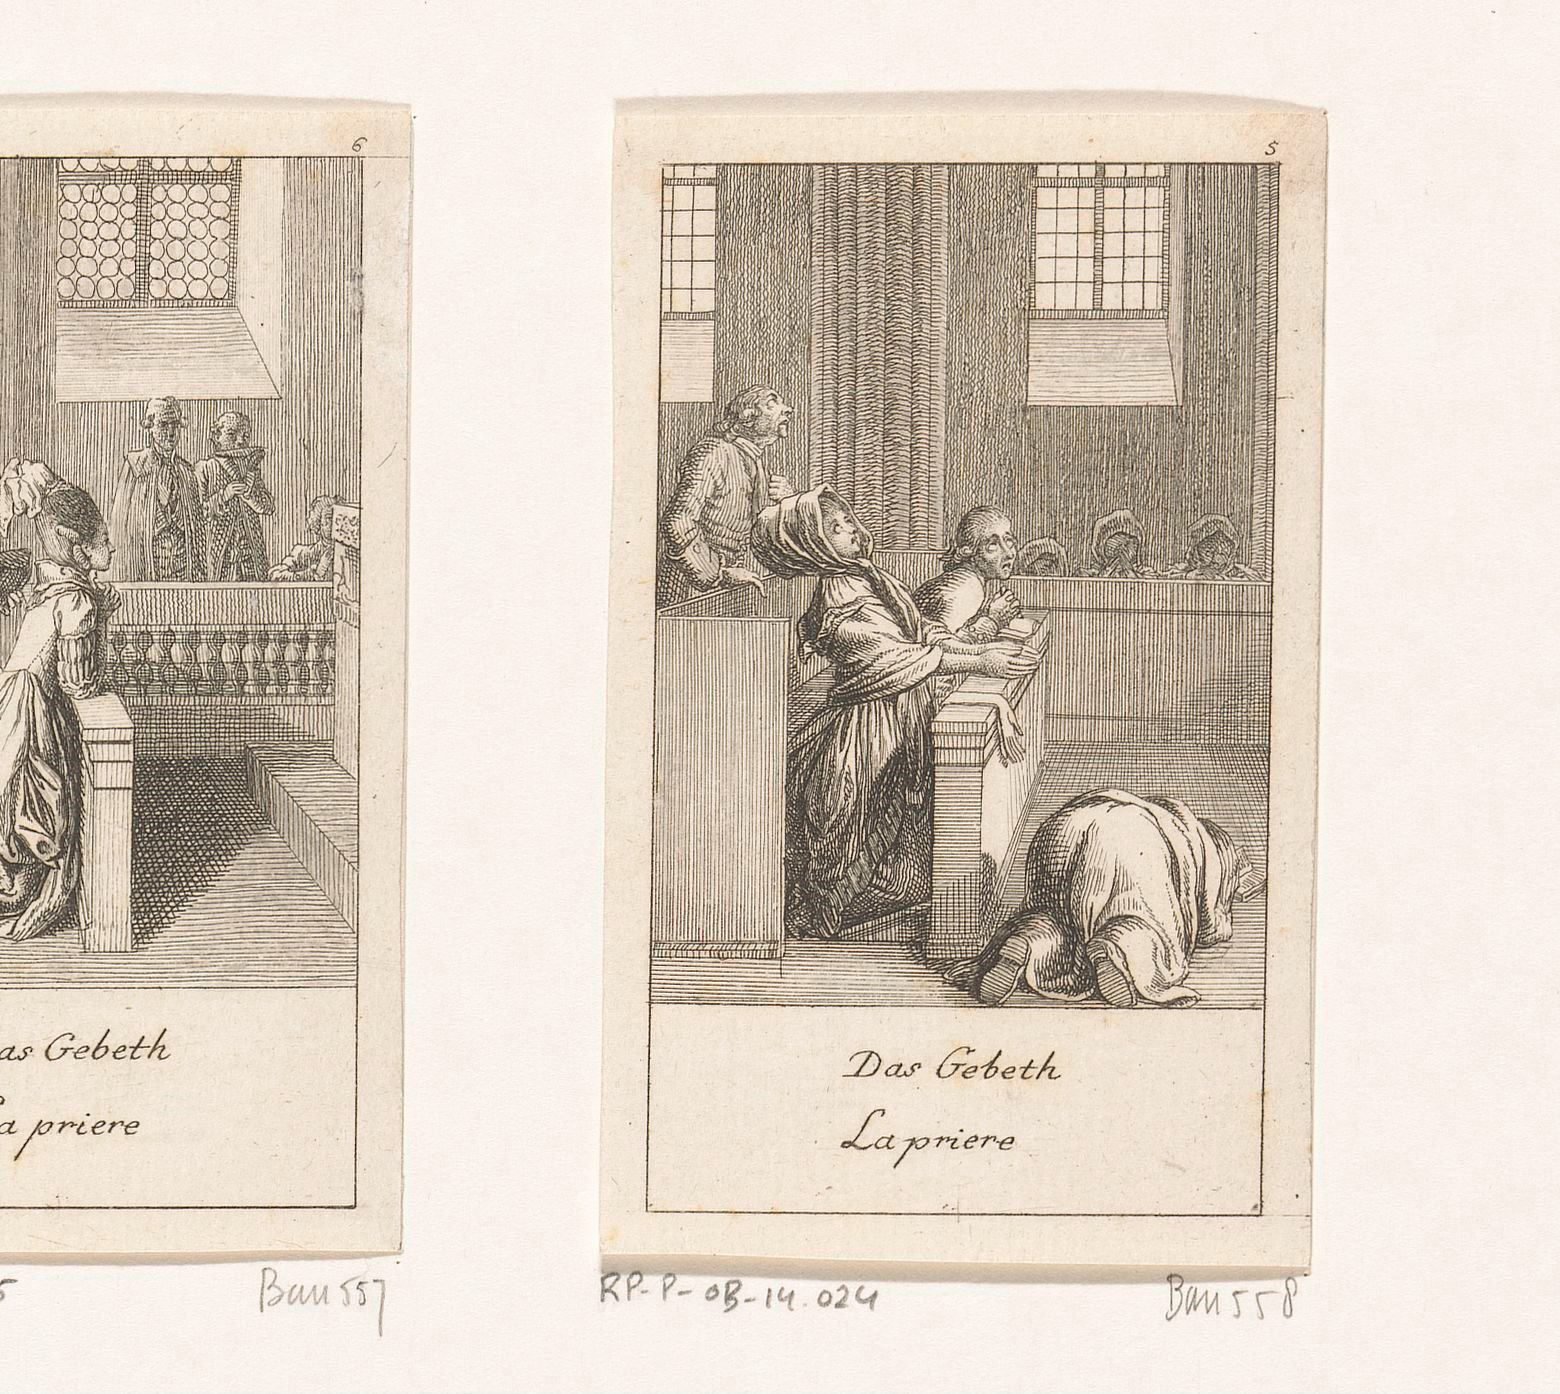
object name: print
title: Biddende kerkgangers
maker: daniel nikolaus chodowiecki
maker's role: draughtsman, print maker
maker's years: 1726-1801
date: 1778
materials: paper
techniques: etching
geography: berlin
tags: physicist, interior of church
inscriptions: collector's mark: Lugt 2228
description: Vijfde prent uit een serie van twaalf taferelen die 'Natürliche und affectirte Handlungen des Lebens' (eerste serie) illustreren waarin 'natuurlijk' en 'geaffecteerd' gedrag op karikaturale wijze tegenover elkaar worden gezet. Deze taferelen zijn op een plaat geëtst. Deze serie, voorzien van toelichtingen door Georg Christoph Lichtenberg, is ook gebruikt in: Goettinger Taschen Calender vom Jahre 1779. Göttingen: Johann Christian Dieterich.